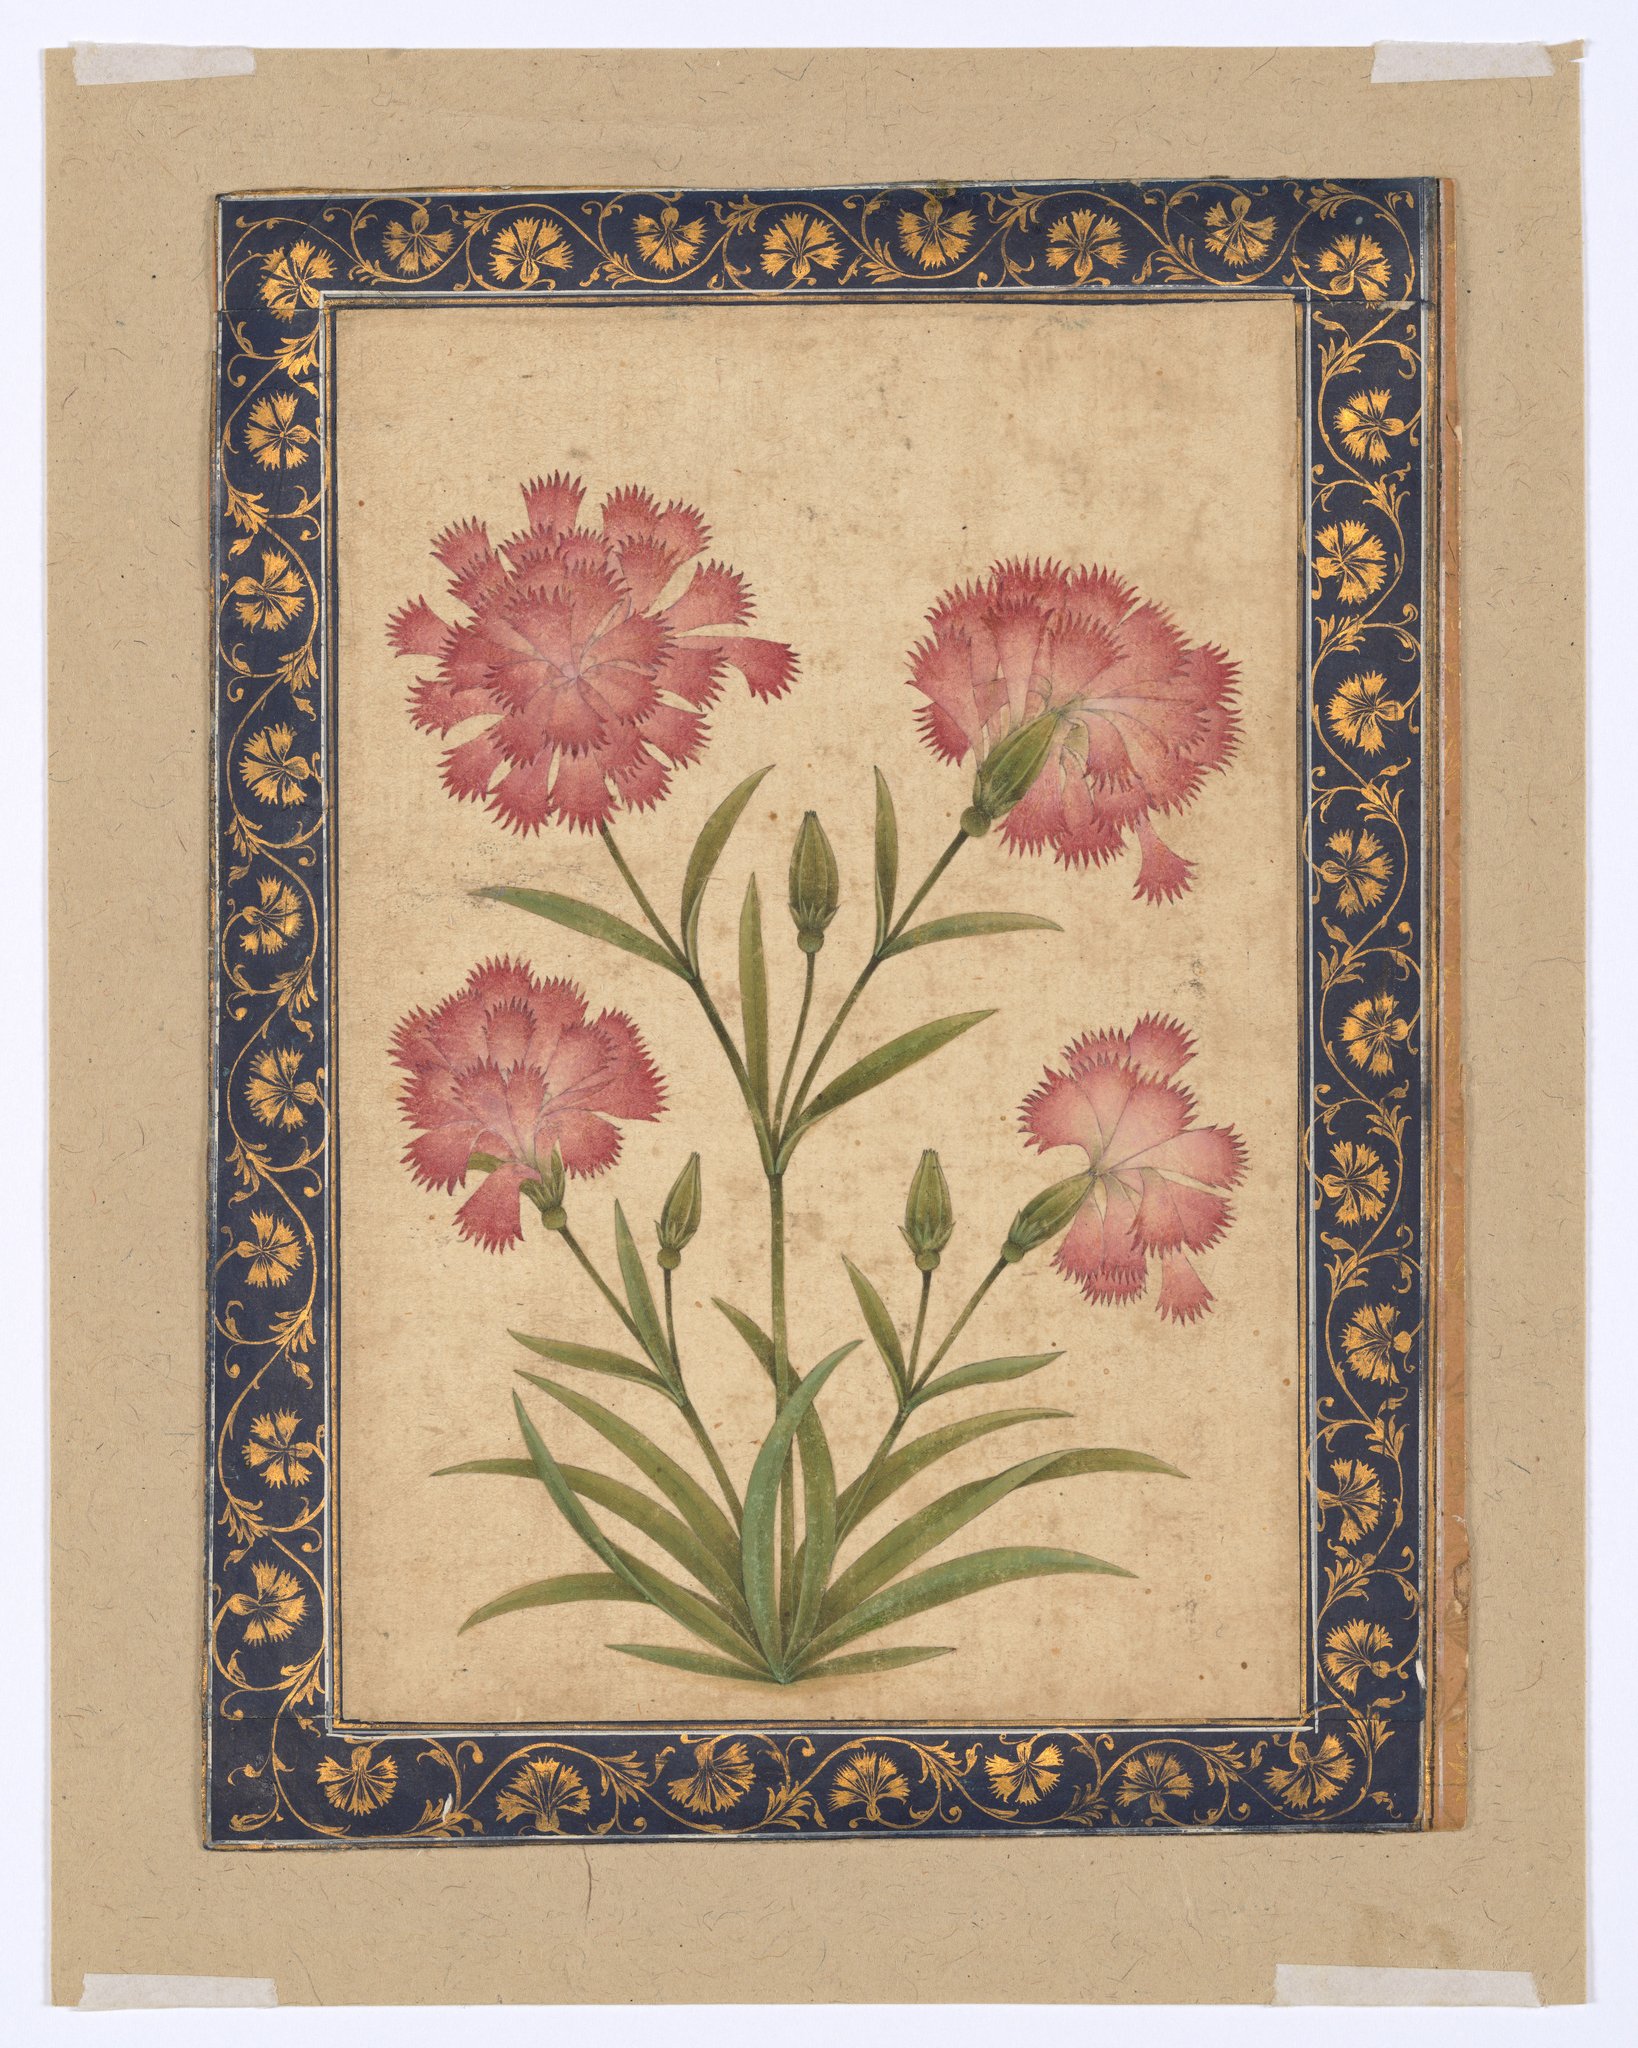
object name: illustrated single work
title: Botanical Painting: Dianthus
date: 1630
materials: paper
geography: india